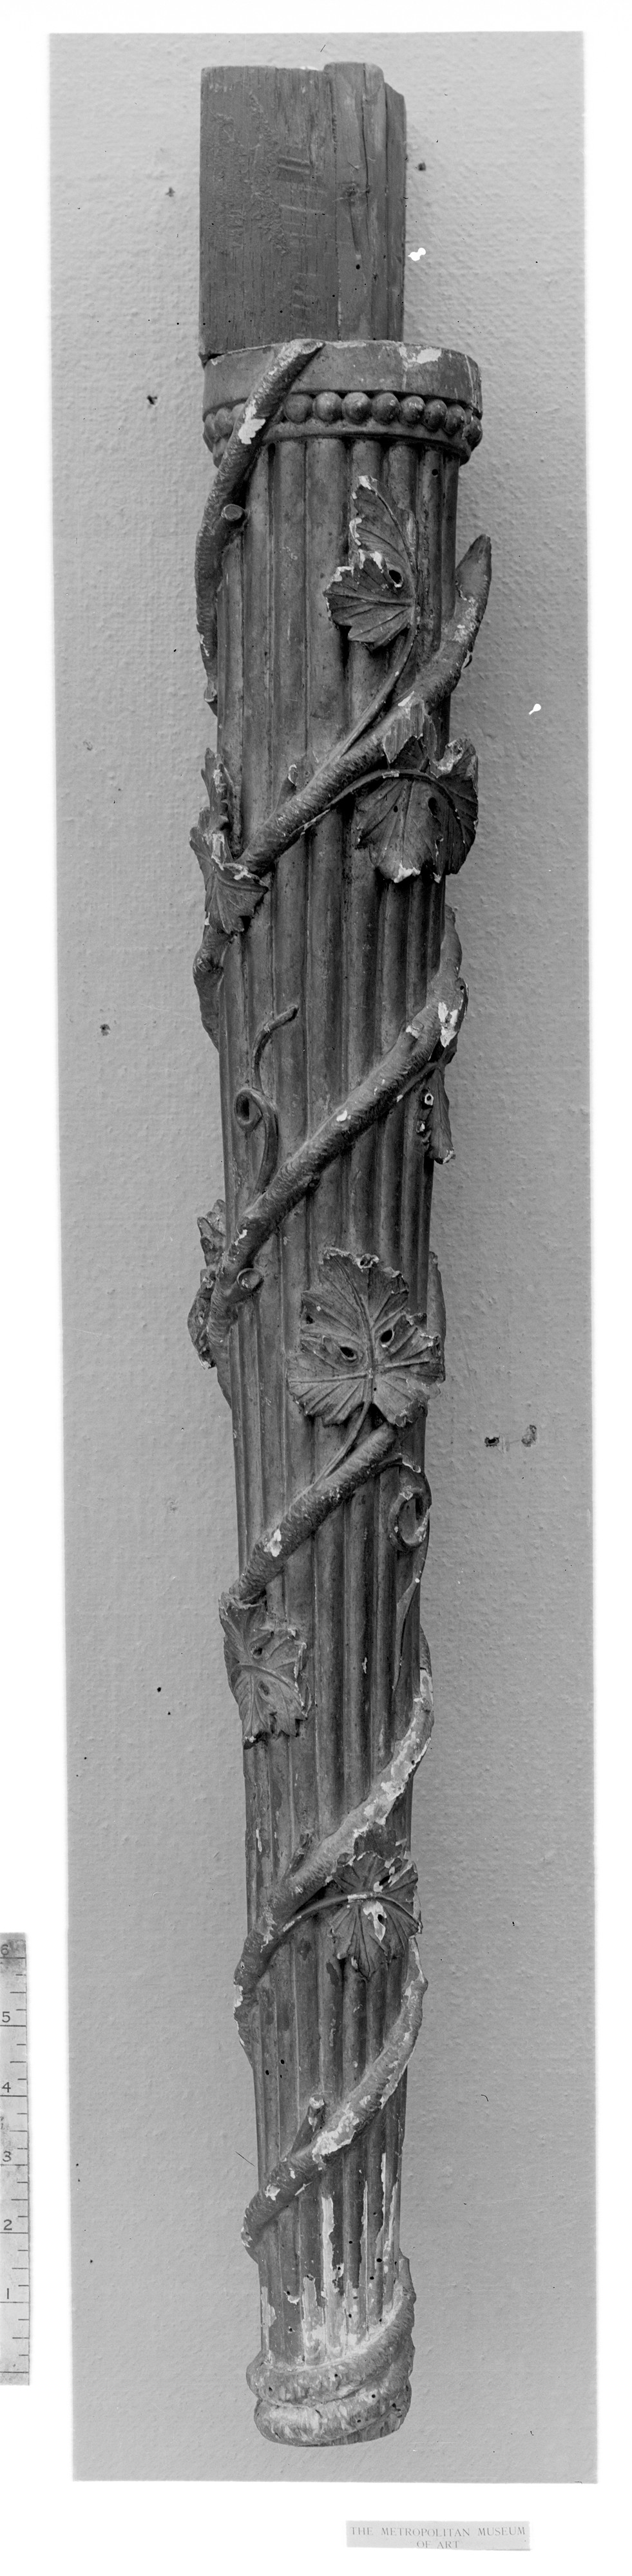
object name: table leg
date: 1701-1800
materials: gilt, wood